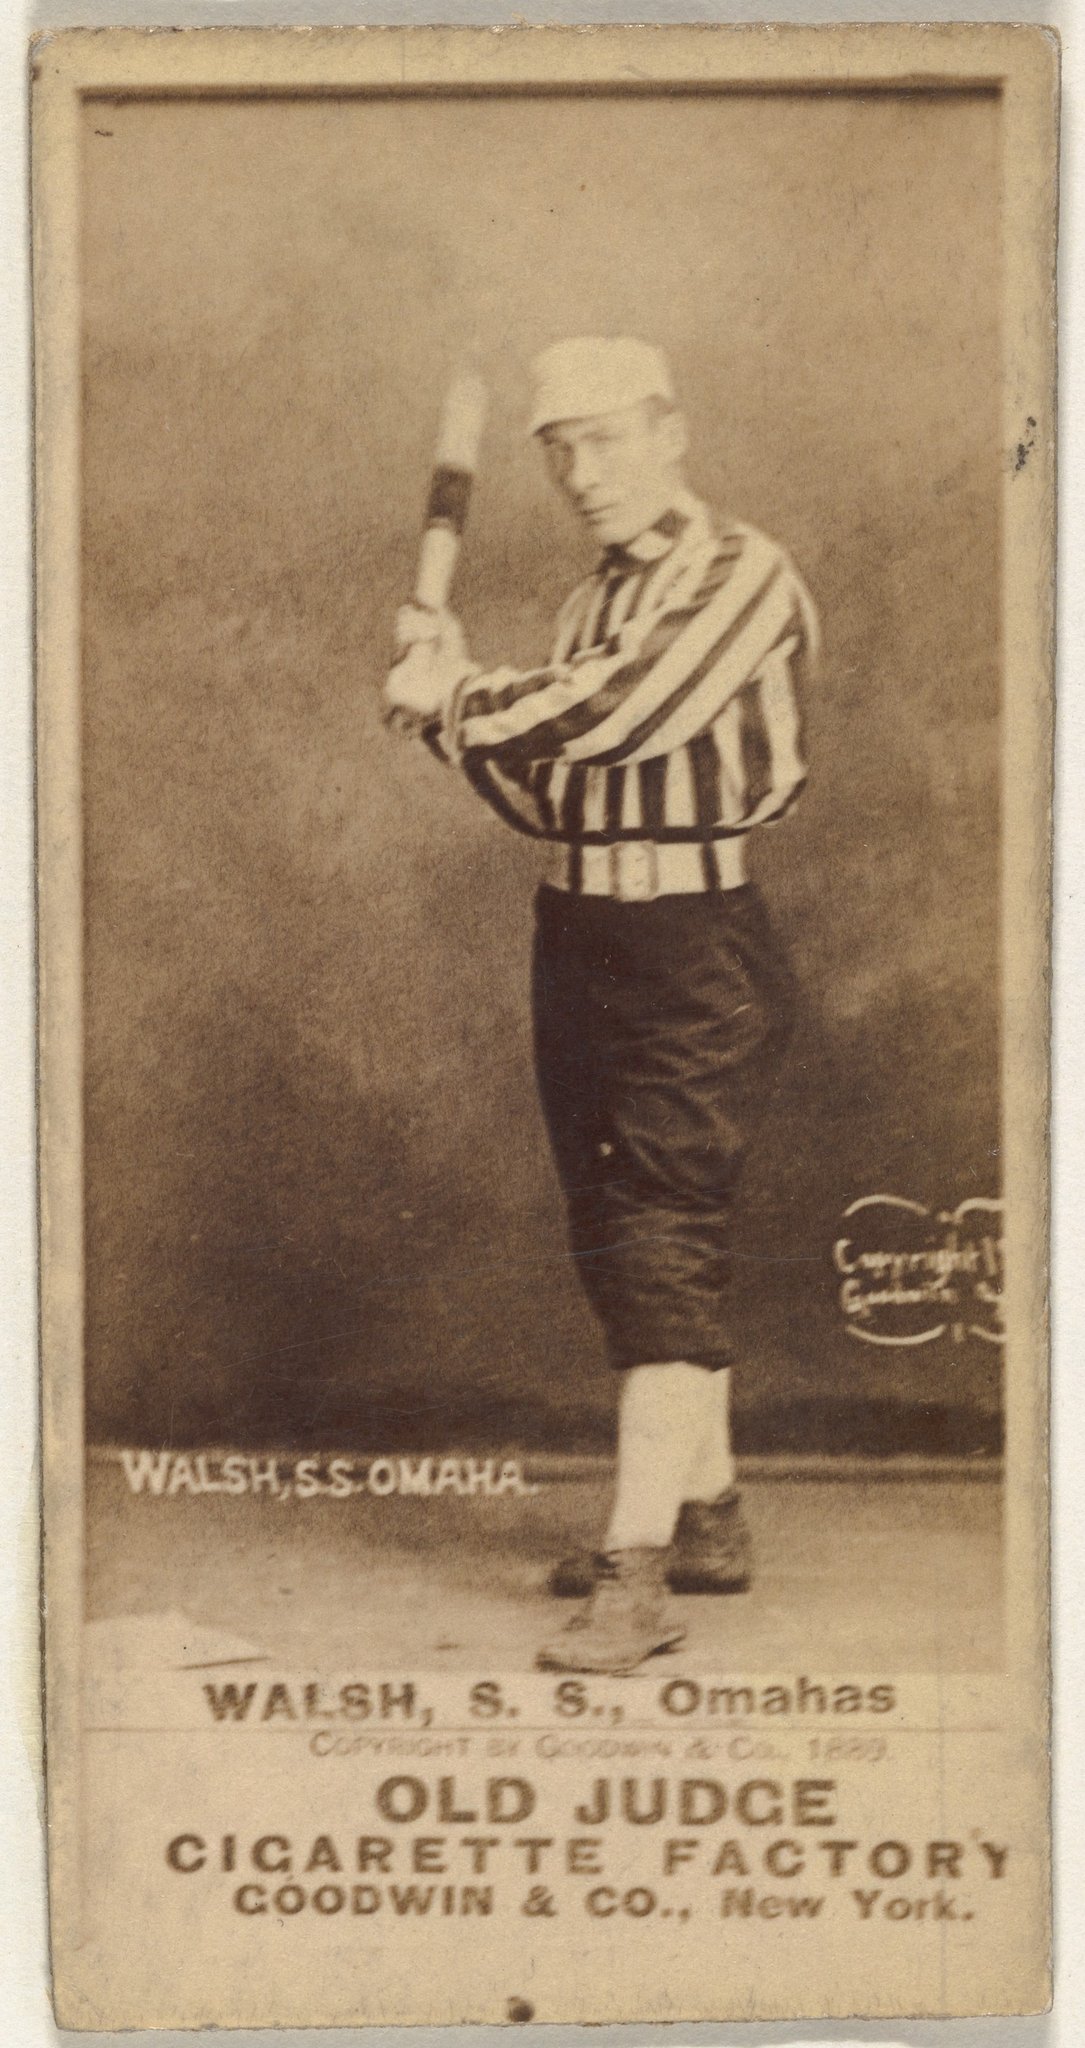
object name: baseball card, photograph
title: Joseph R. "Joe" Walsh, Shortstop, Omaha Omahogs/ Lambs, from the Old Judge series (N172) for Old Judge Cigarettes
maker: goodwin & company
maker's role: publisher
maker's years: 1850-1950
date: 1889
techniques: albumen silver print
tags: men,portraits,baseball,athletes